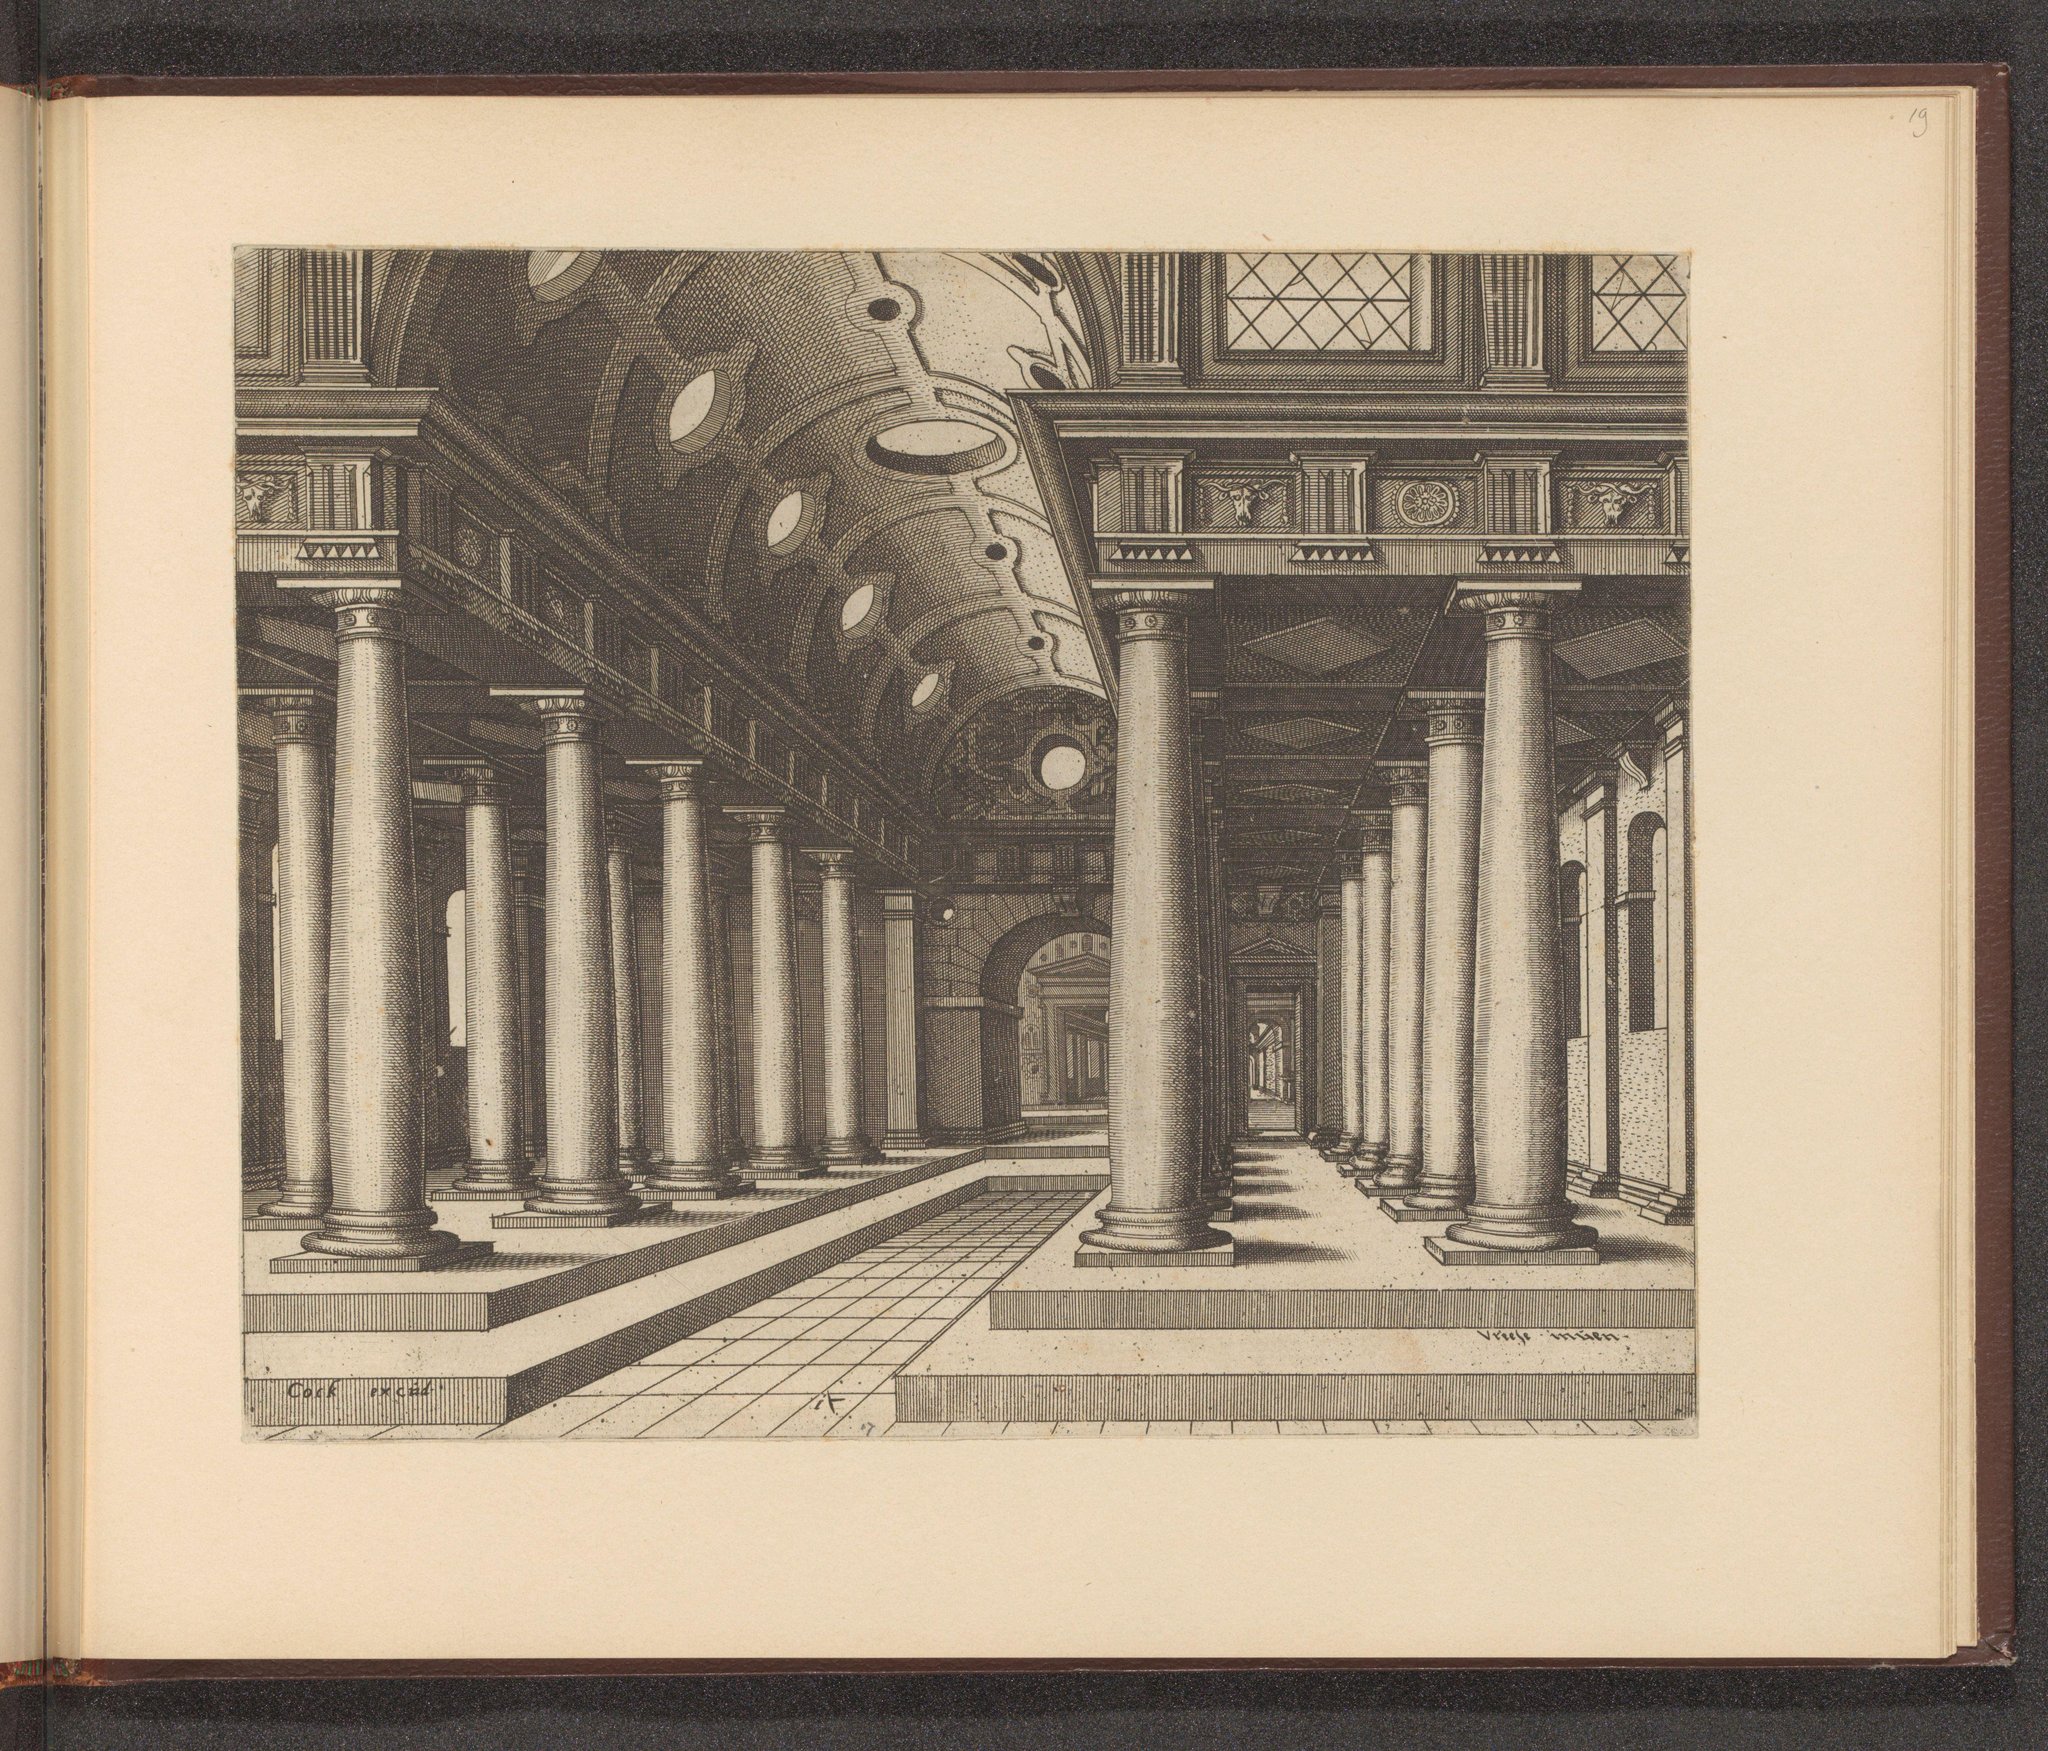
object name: print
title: Scenographiae, sive Perspectivae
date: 1563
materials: paper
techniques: etching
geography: antwerp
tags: column, pillar ~ architecture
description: Hal met tongewelf en twee rijen zuilen van de Toscaanse orde. Rechts van het midden het verdwijnpunt. Prent maakt deel uit van een album.